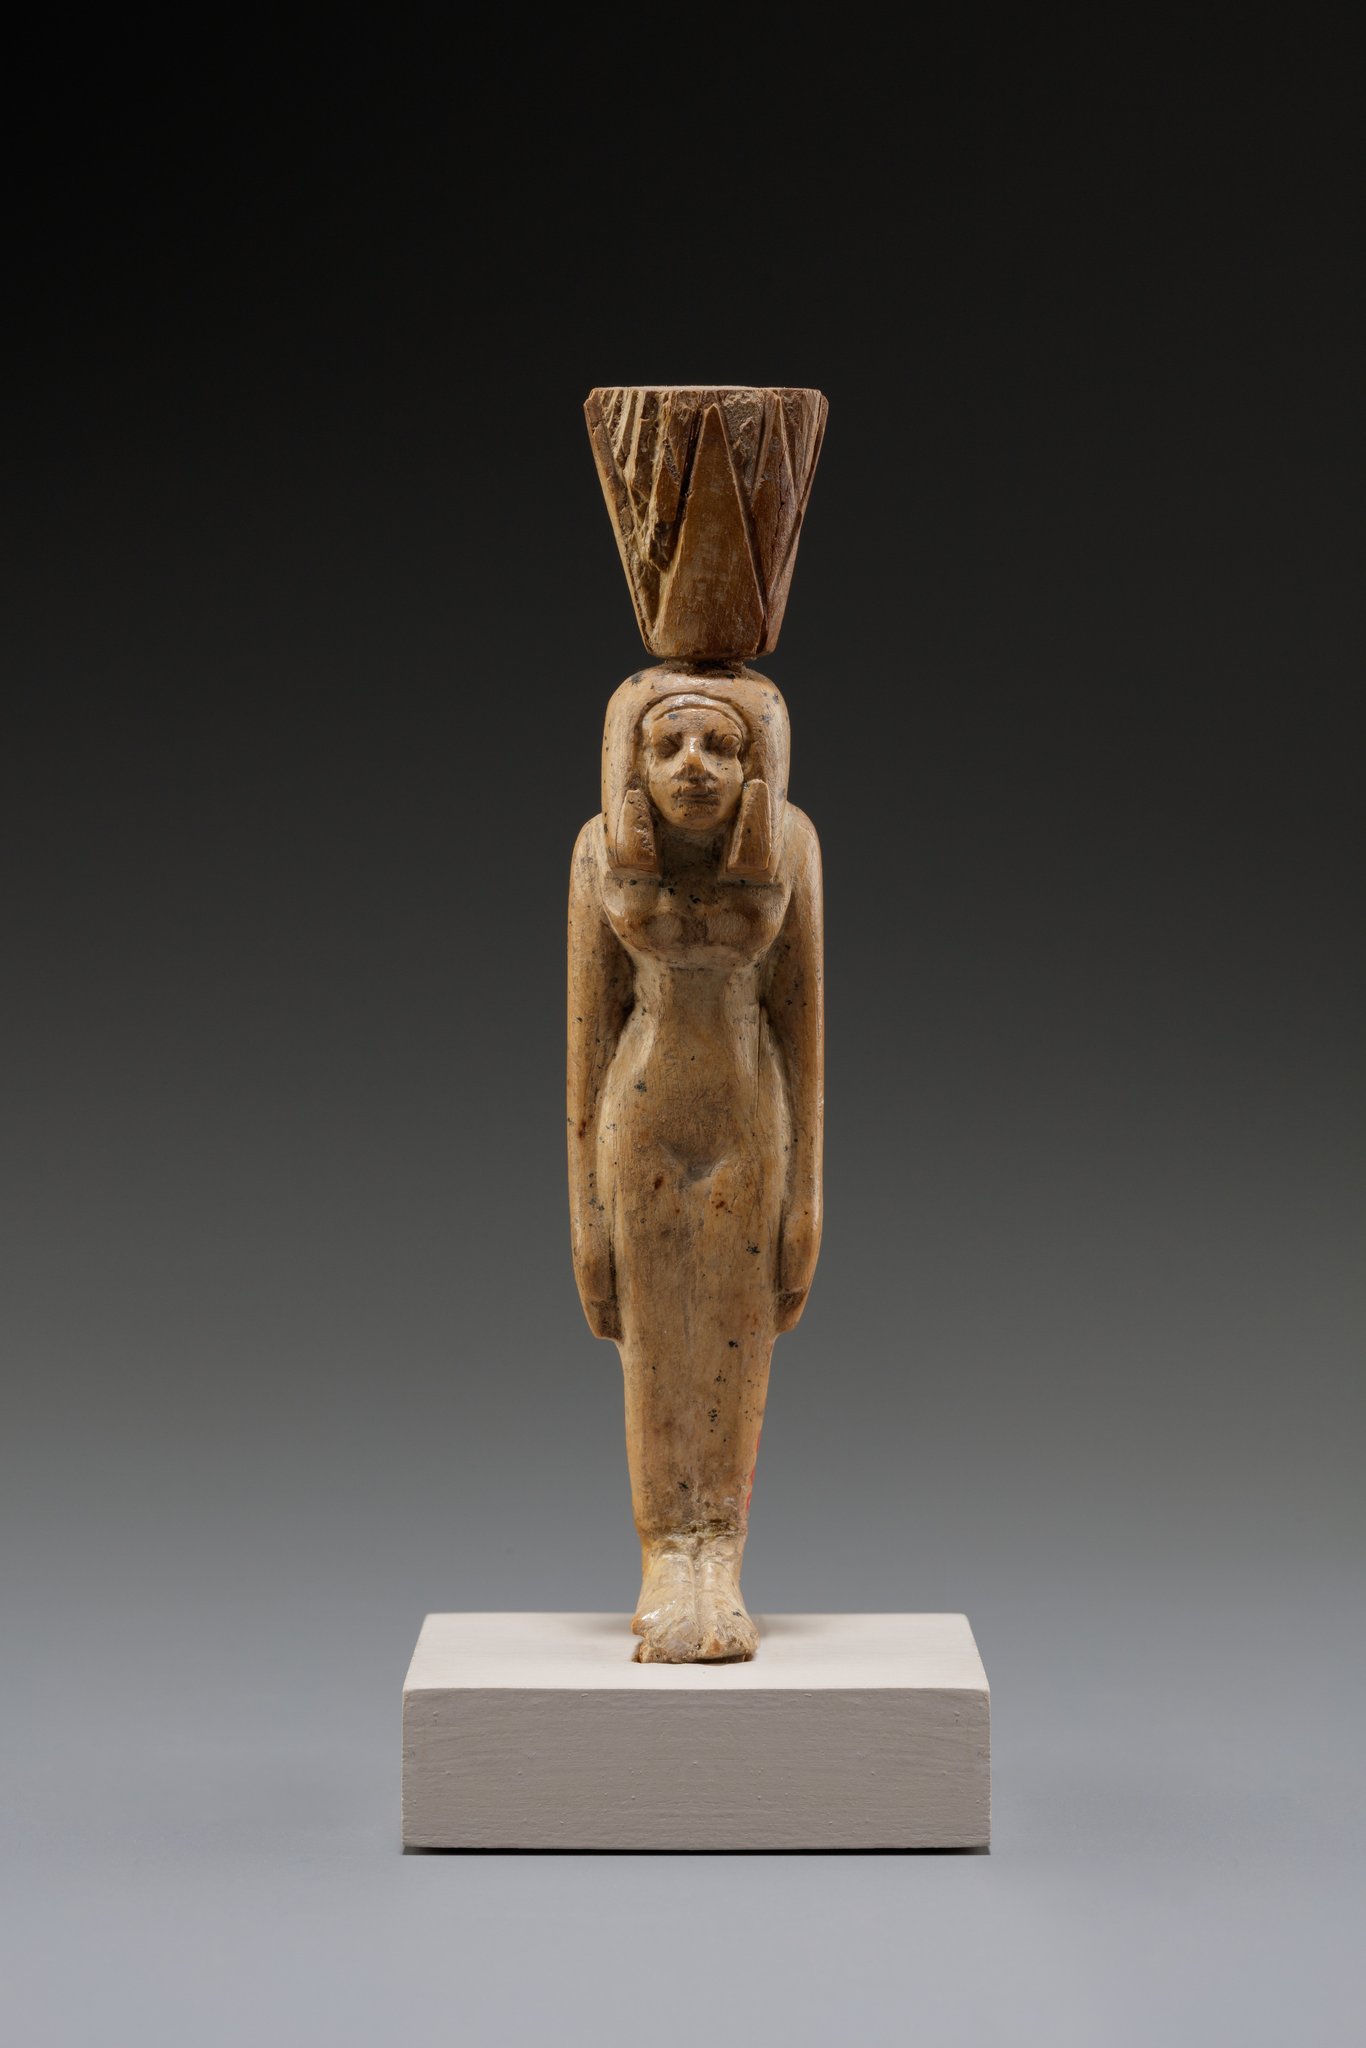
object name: statuette, standing goddess, upper egypt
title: Goddess of Upper Egypt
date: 1550-1295 BCE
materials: ivory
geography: egypt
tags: goddess